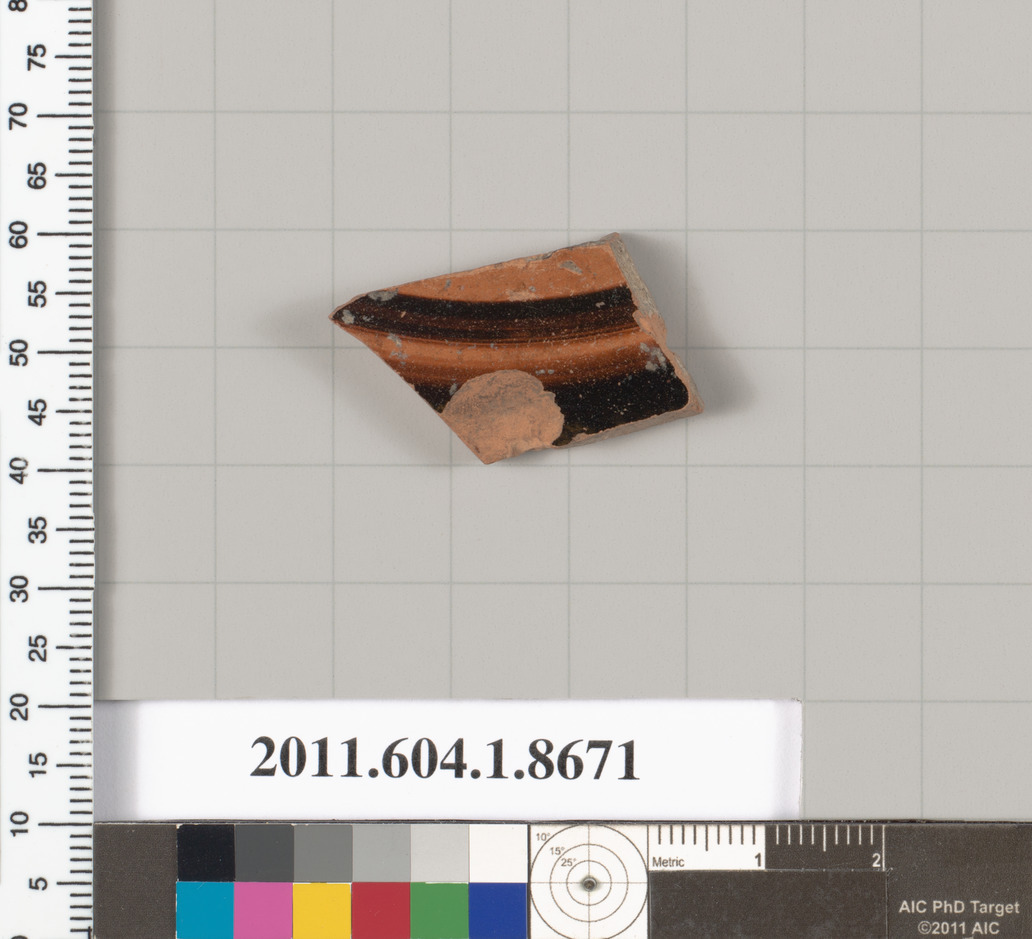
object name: kylix fragment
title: Terracotta fragment of a stemless kylix (drinking cup)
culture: greek, attic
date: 467-435 BCE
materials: terracotta